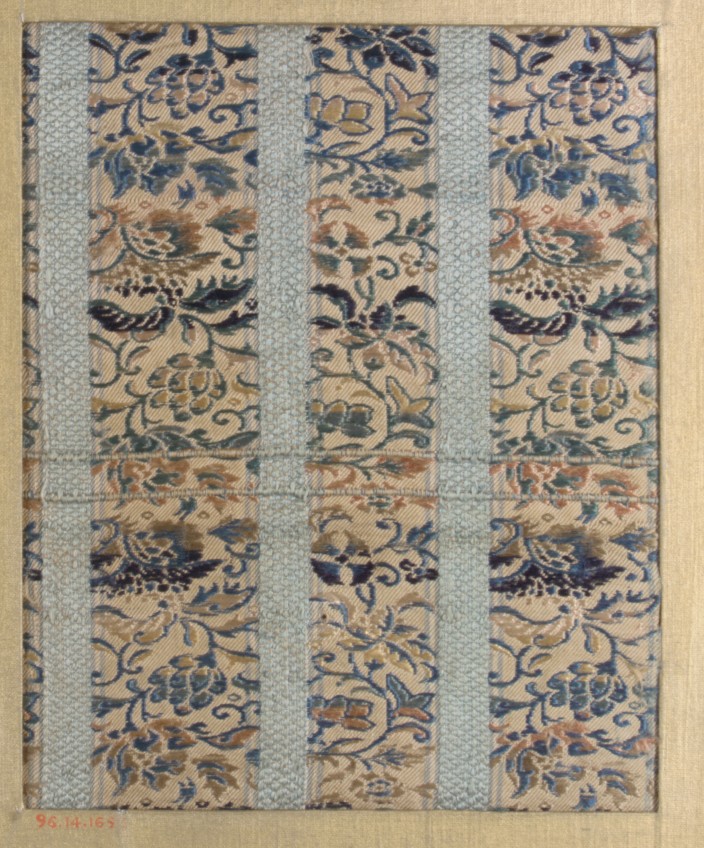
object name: piece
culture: japanese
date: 1701-1900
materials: silk